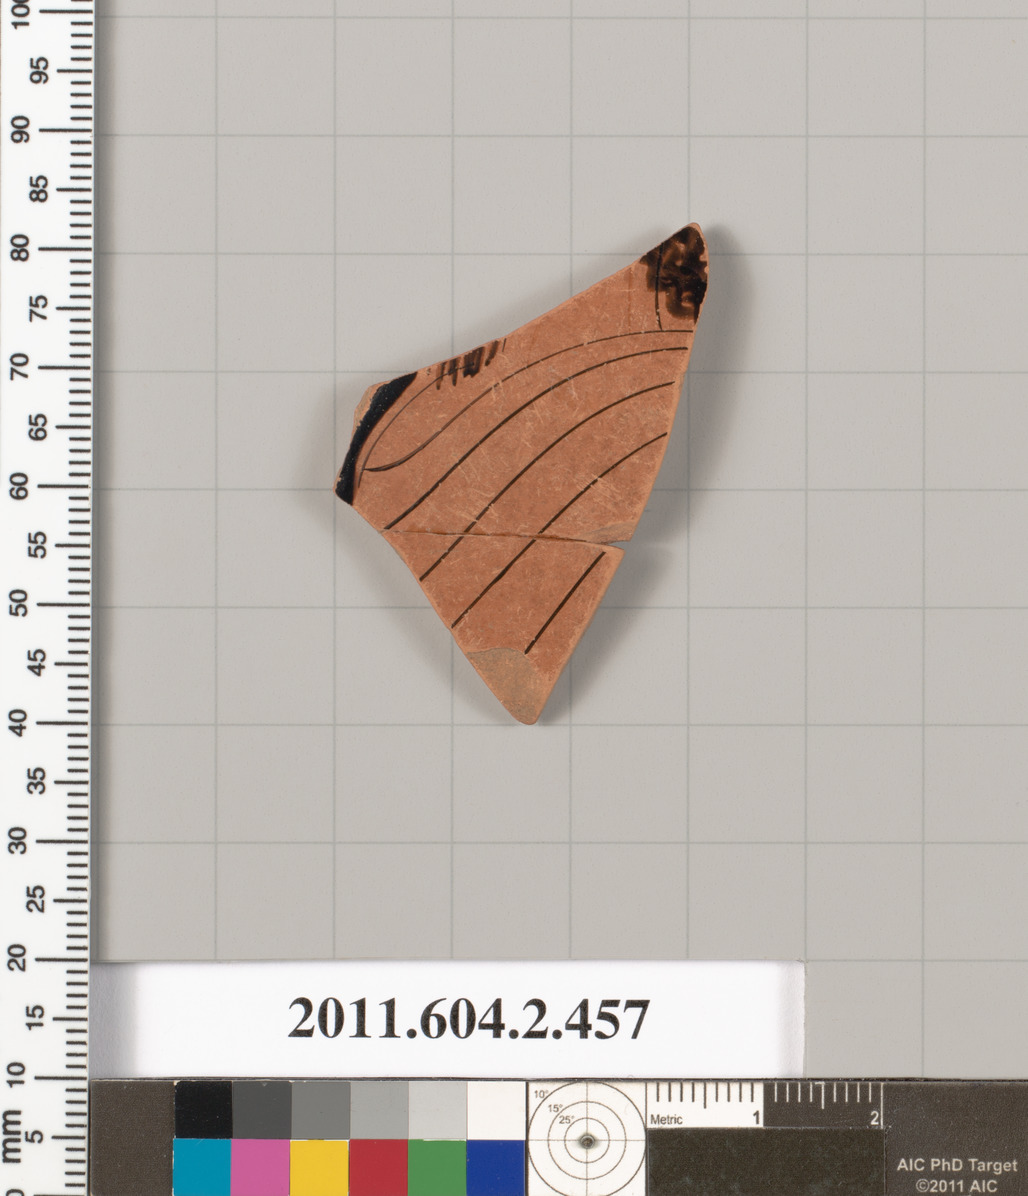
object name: column krater fragment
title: Terracotta fragment of a column-krater (bowl for mixing wine and water)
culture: greek, attic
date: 450-430 BCE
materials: terracotta